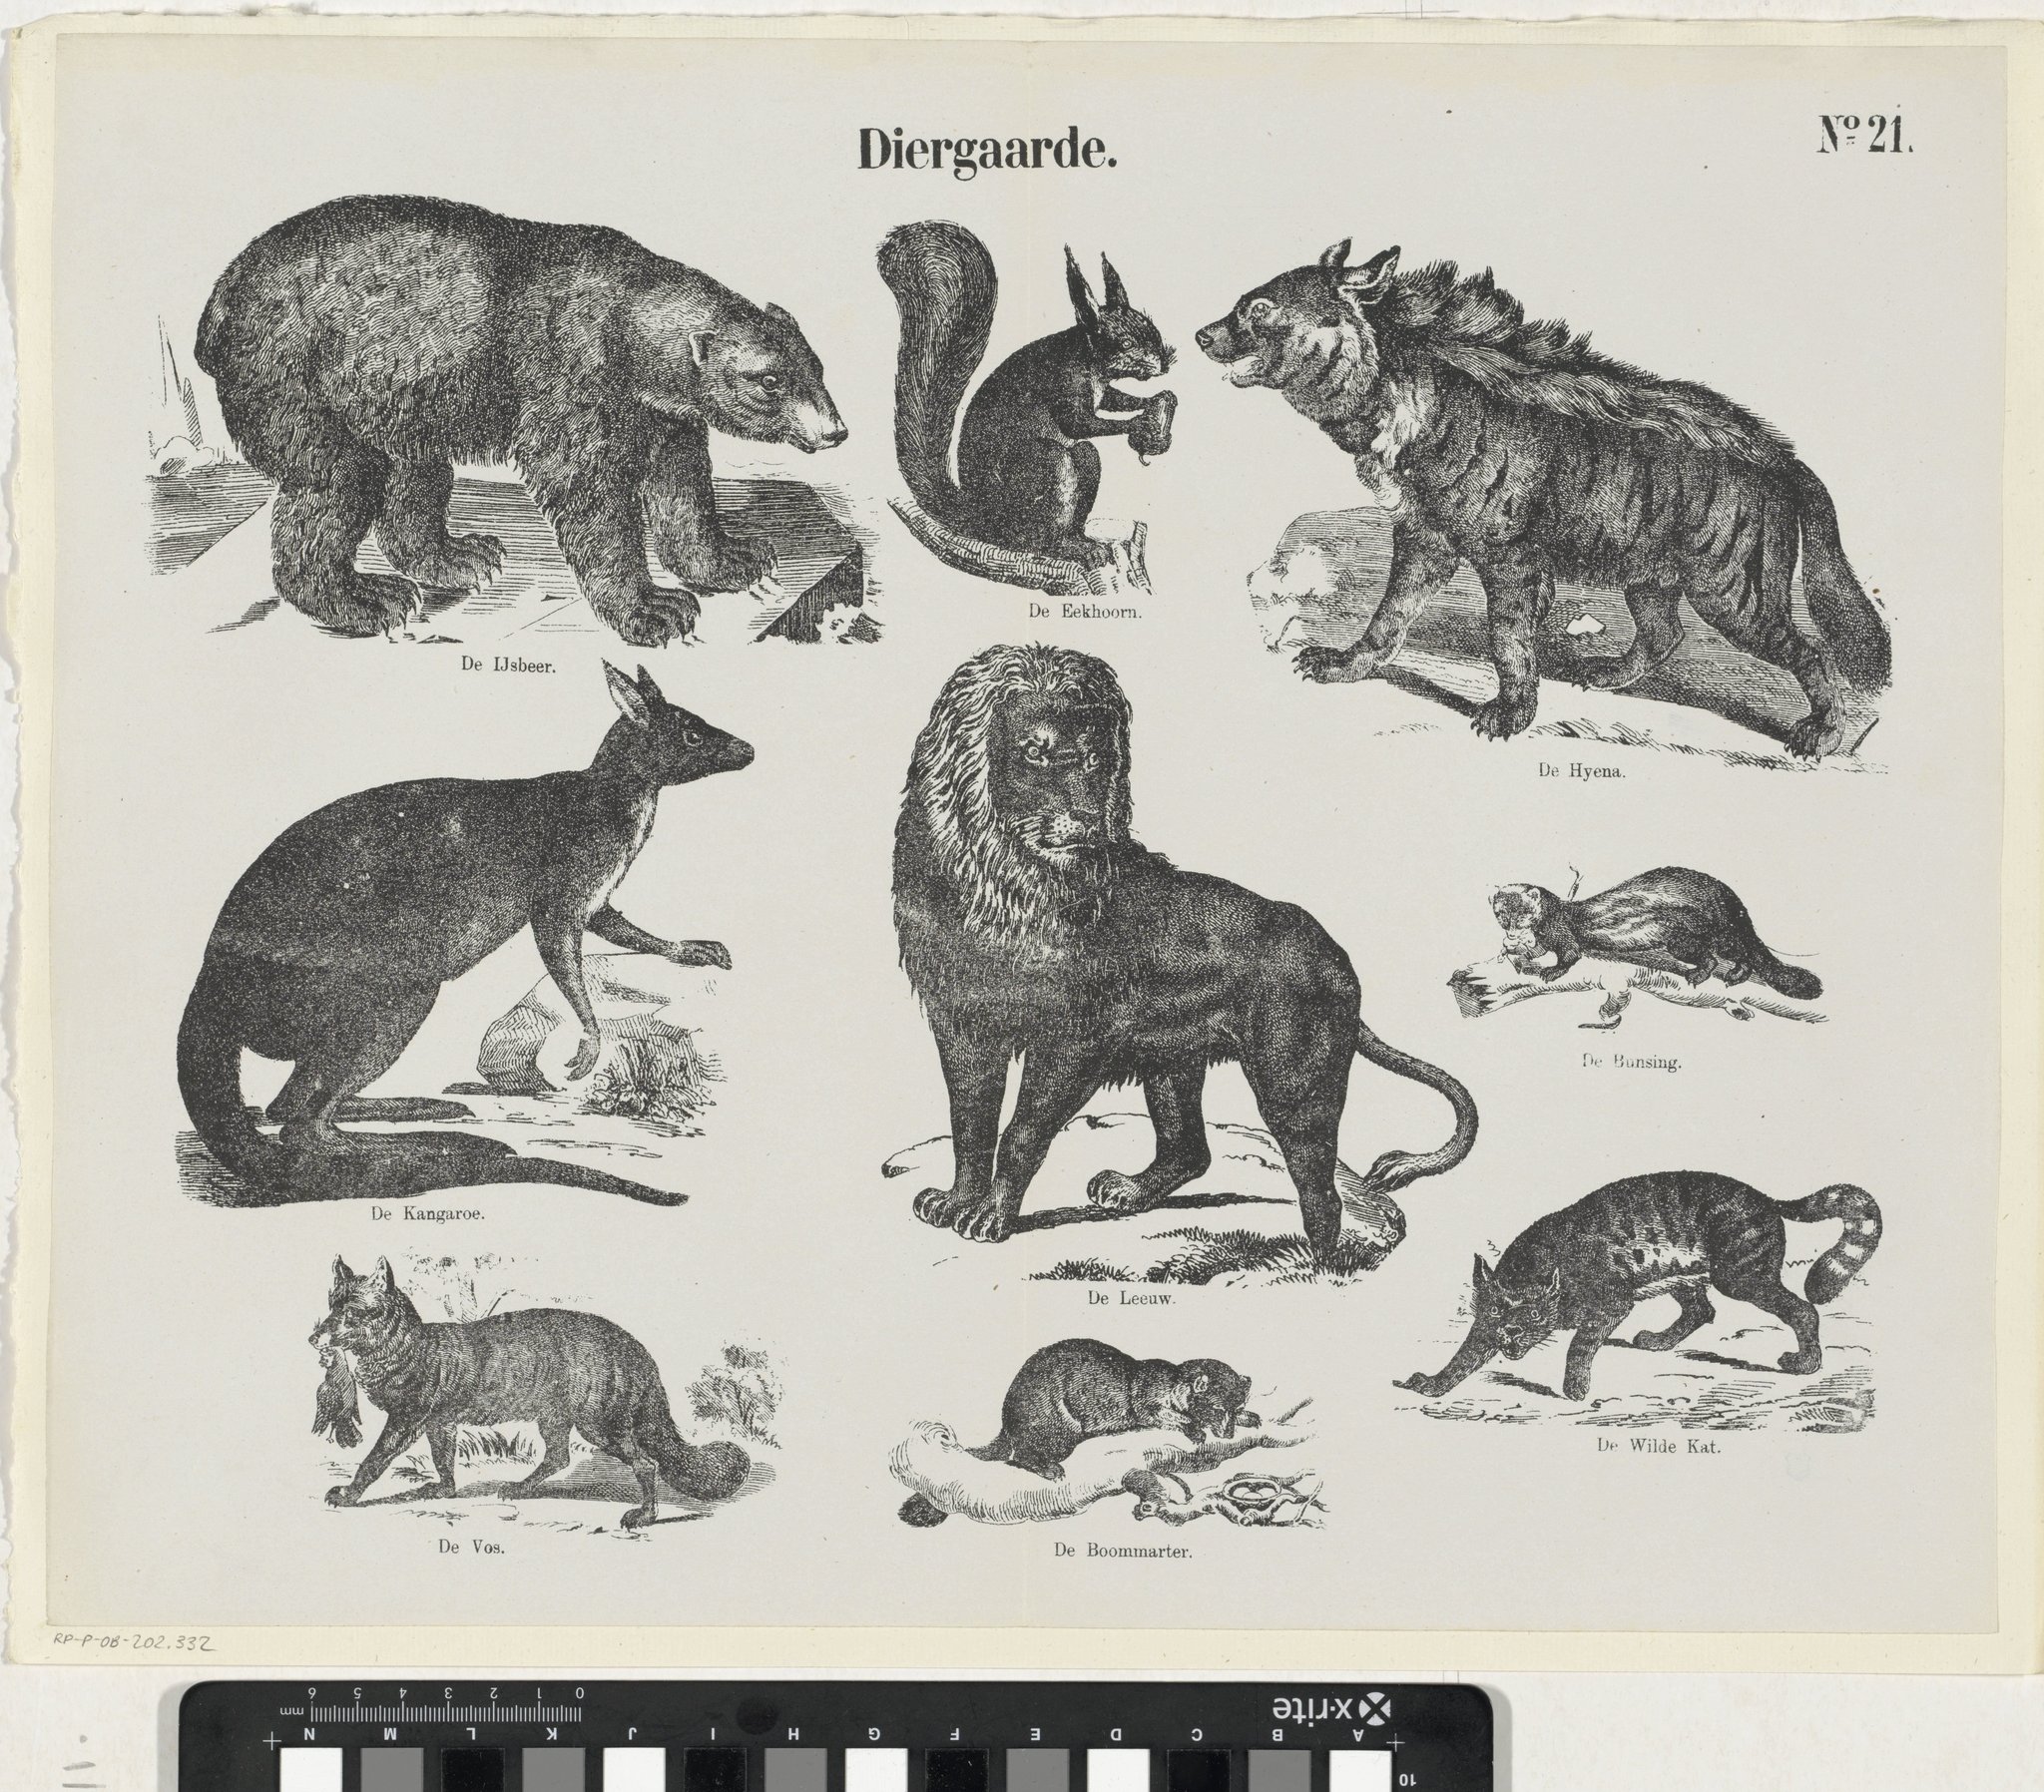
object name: print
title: Diergaarde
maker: Anonymous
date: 1873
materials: paper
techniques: letterpress printing, lithograph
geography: amsterdam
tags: beasts of prey, predatory animals: polar bear, animals, beasts of prey, predatory animals: lion, rodents: squirrel, beasts of prey, predatory animals: fox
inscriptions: collector's mark: Lugt 2760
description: Blad met 9 voorstellingen van dieren, waaronder een ijsbeer, een eekhoorn en een leeuw. Onder elke afbeelding een onderschrift. Genummerd rechtsboven: No. 21.